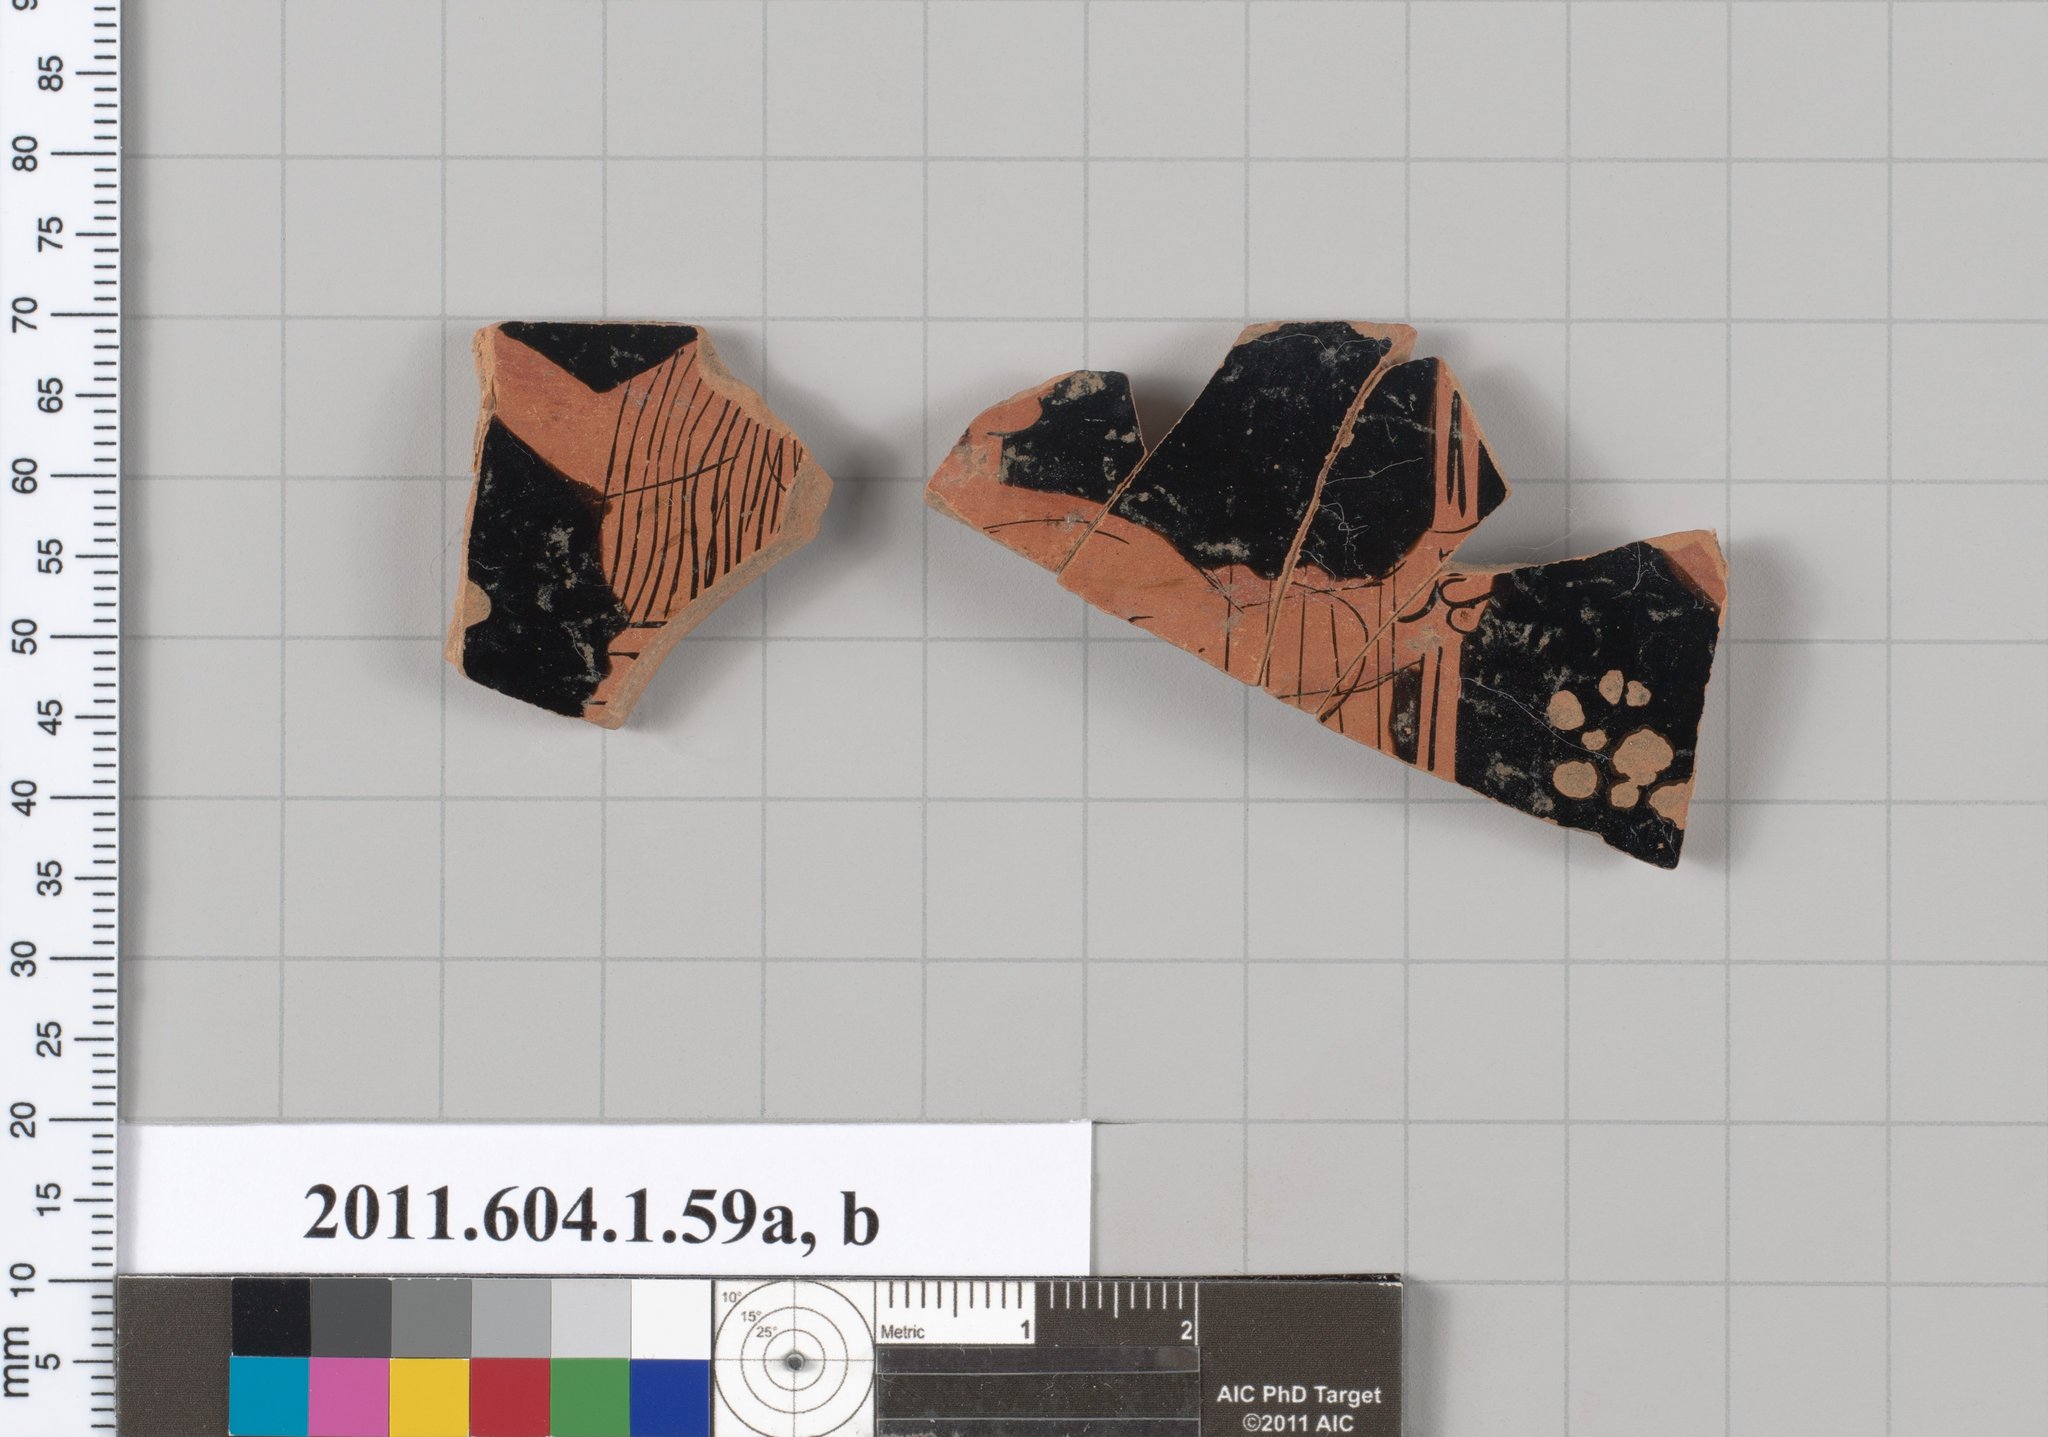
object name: kylix fragment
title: Terracotta fragment of a kylix (drinking cup)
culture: greek, attic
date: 467-435 BCE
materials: terracotta